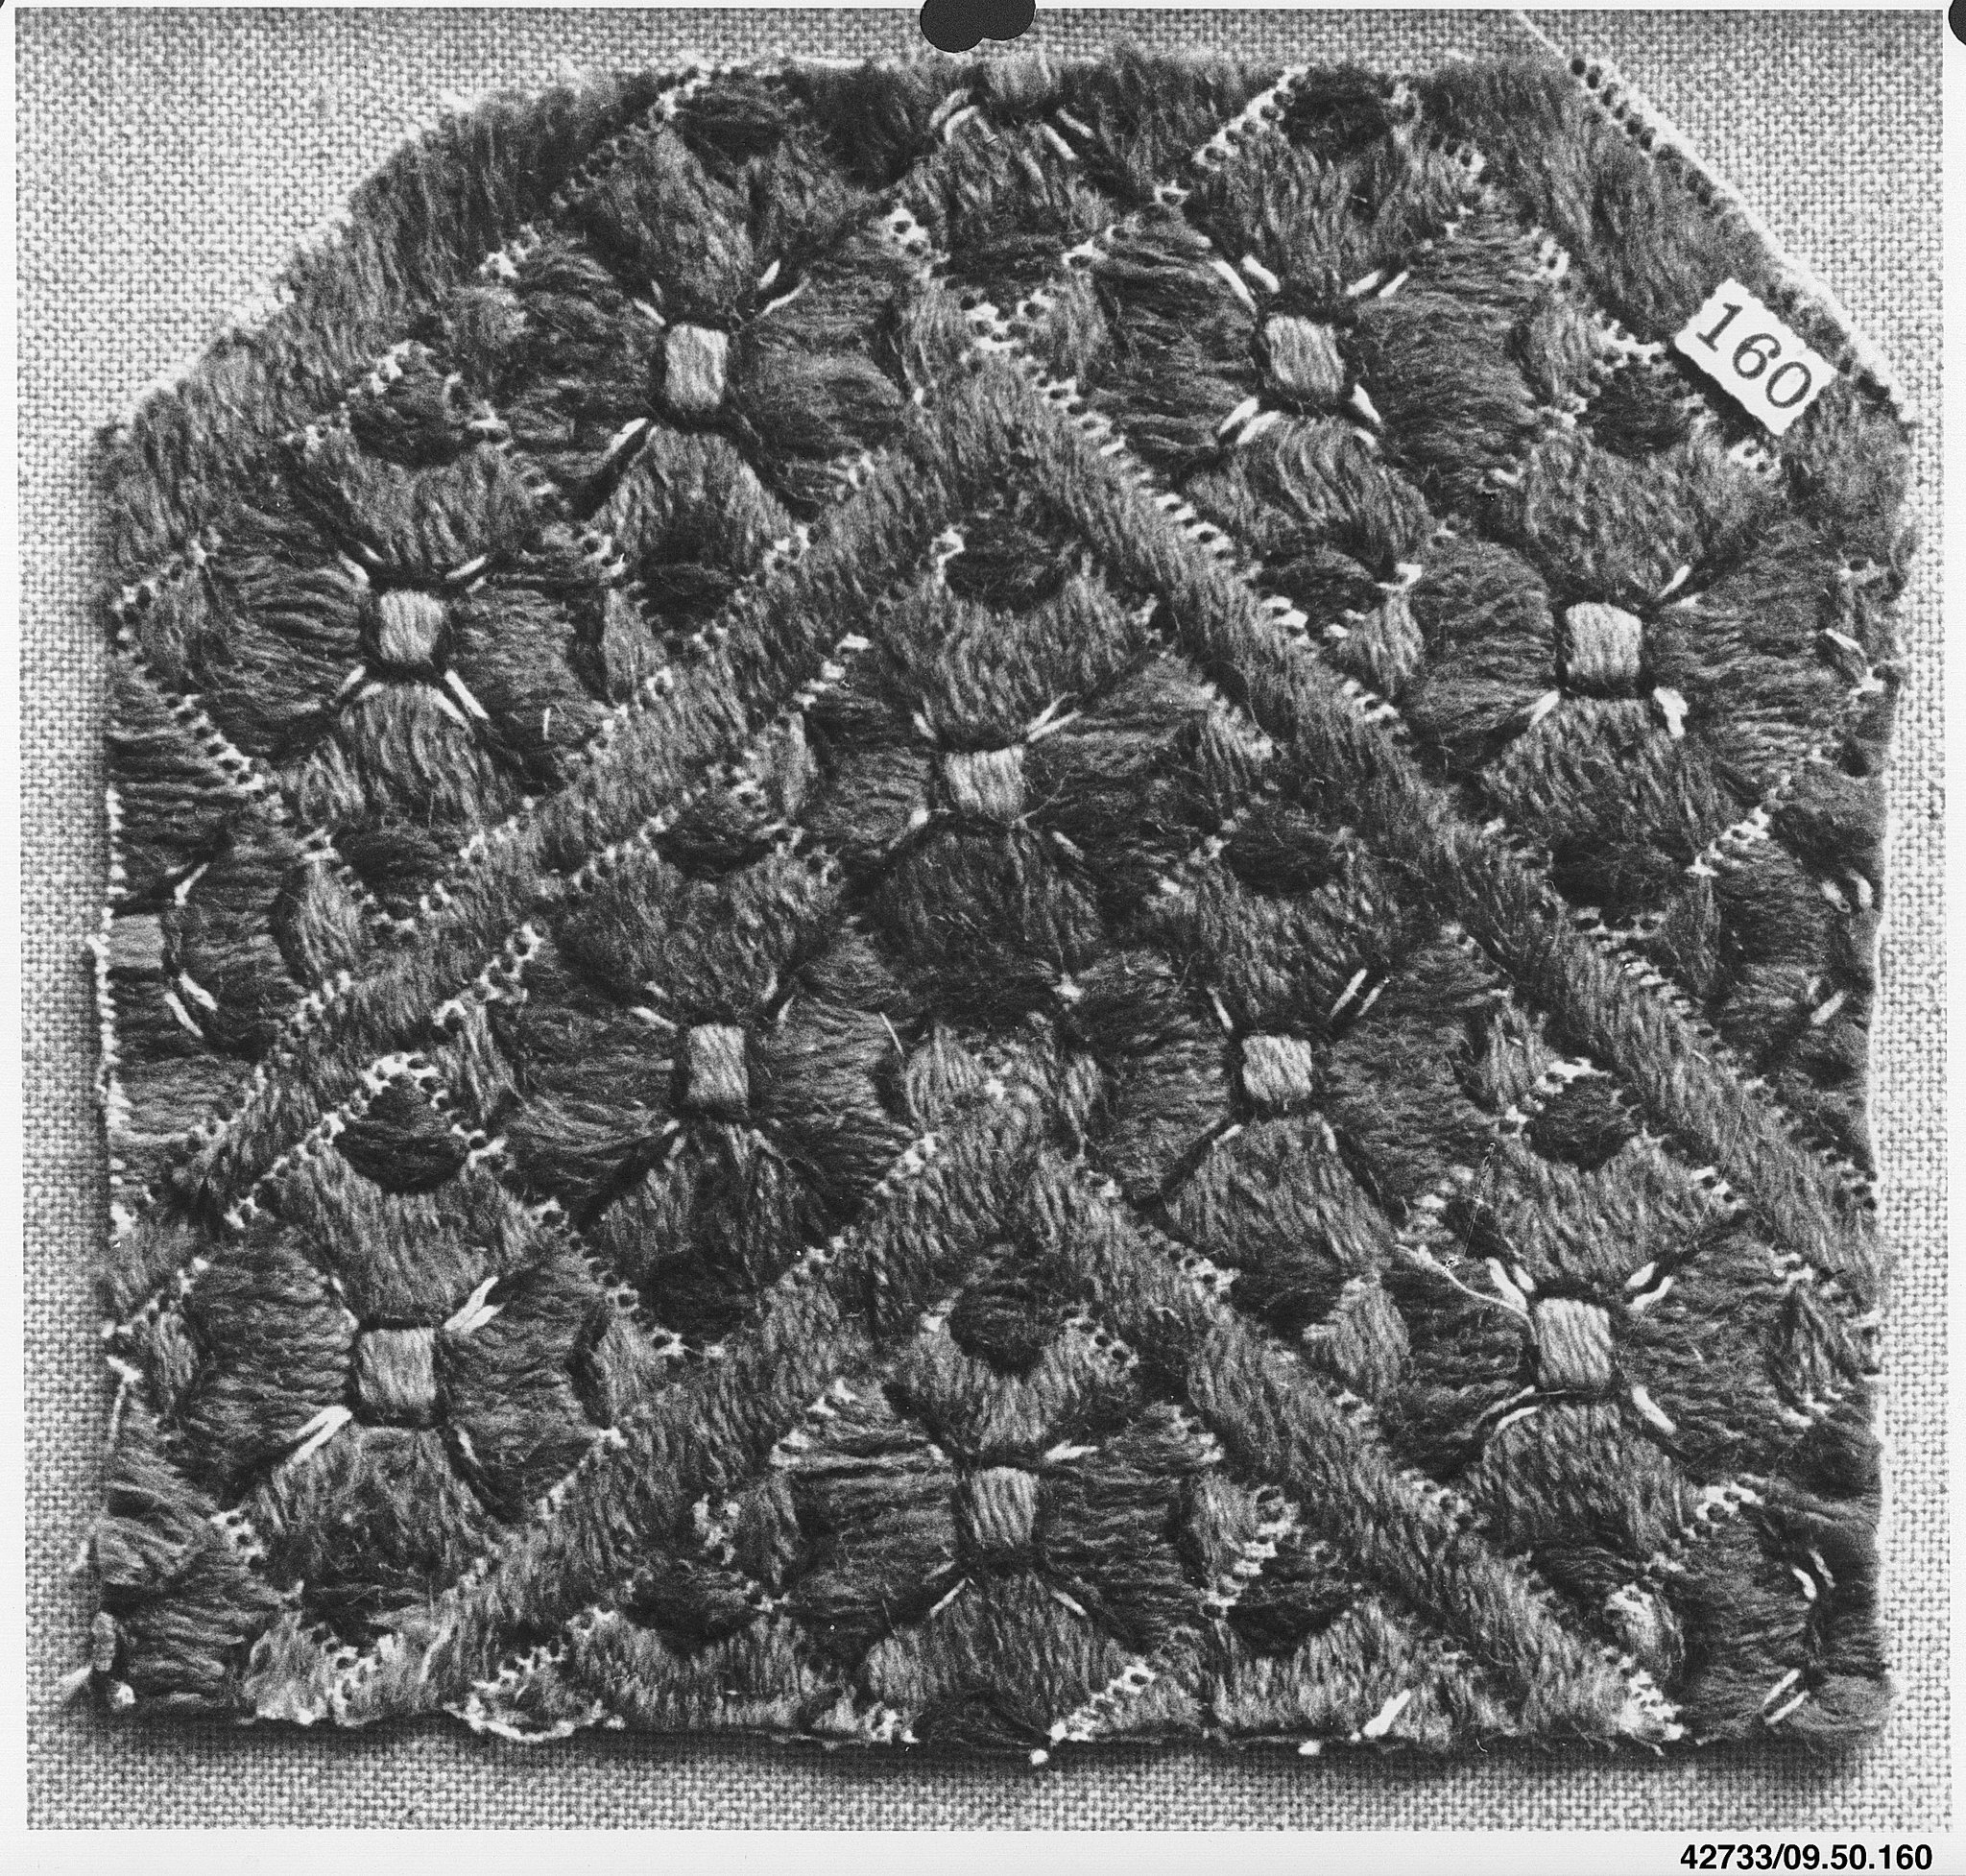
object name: costume fragment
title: Peasant costume fragment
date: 1701-1900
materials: canvas, wool